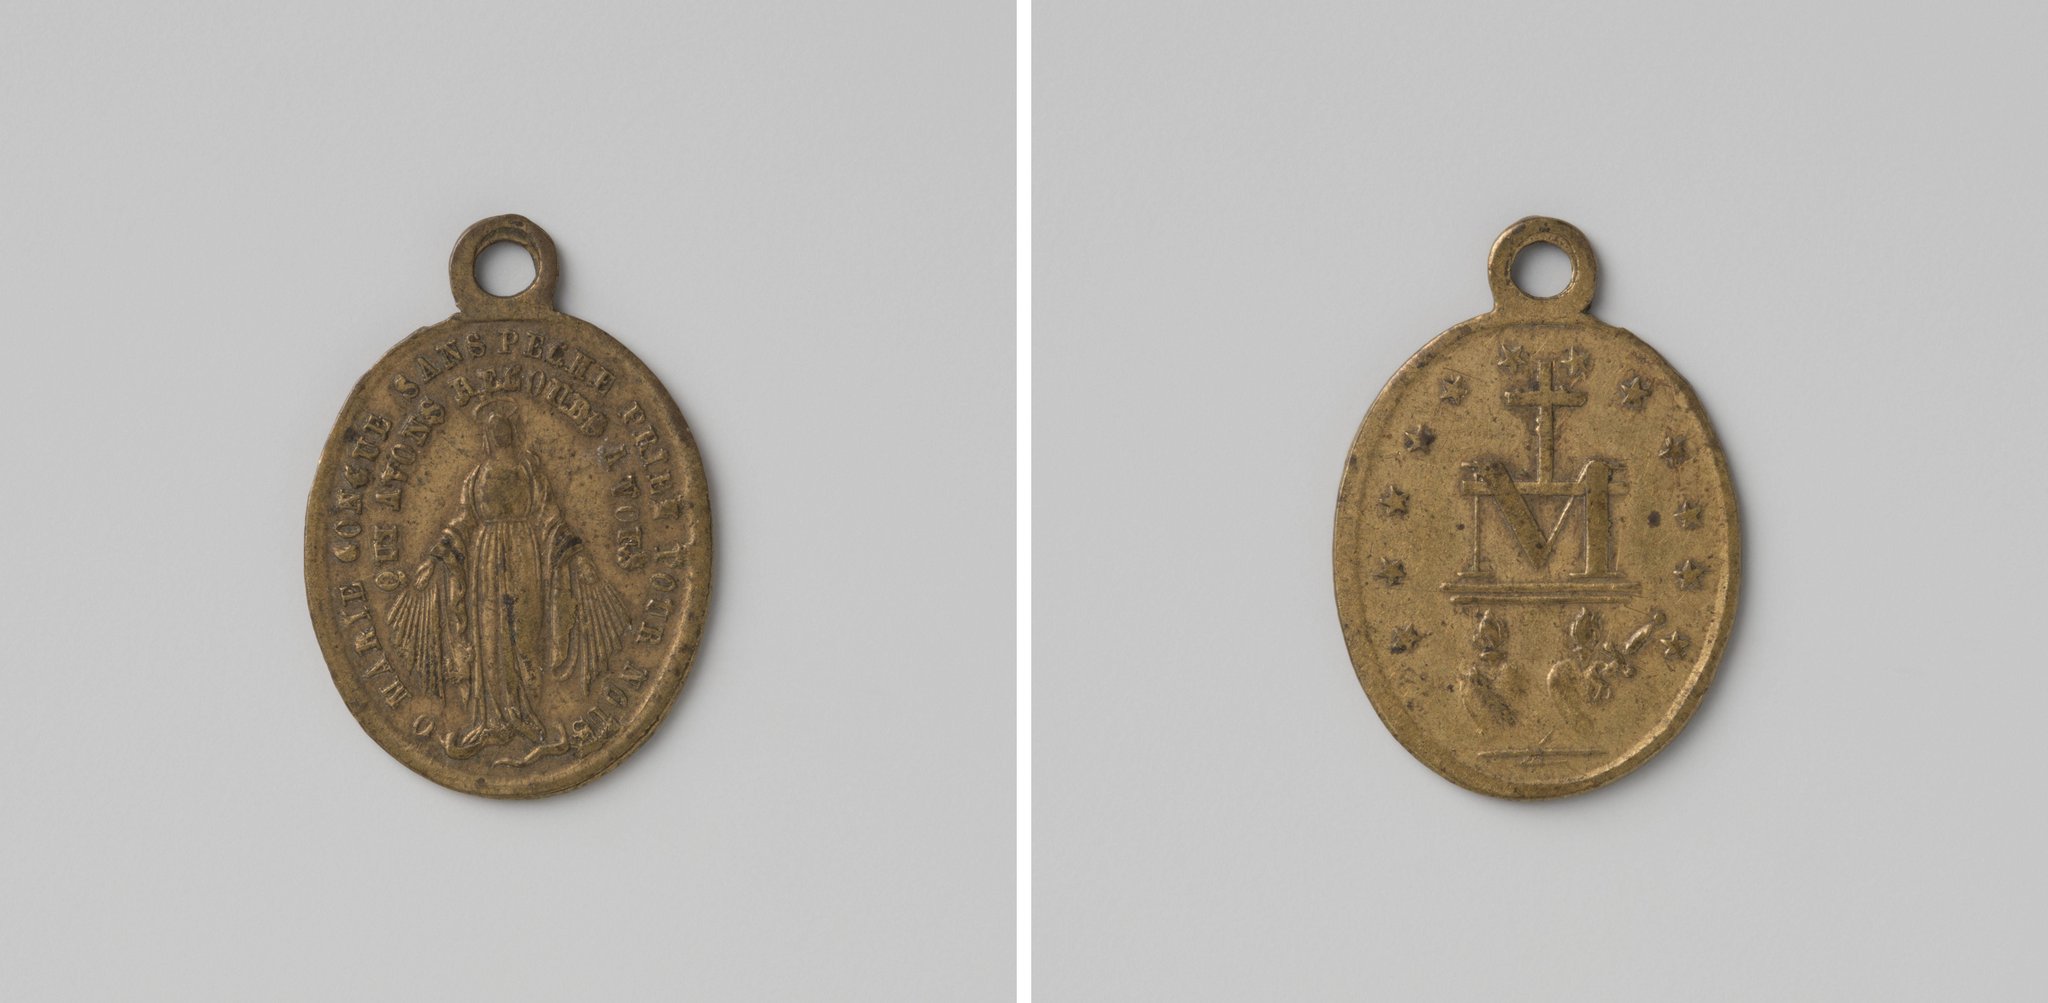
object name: devotional token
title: Mirakuleuze medaille, devotiepenning gewijd aan de Onbevlekte Ontvangenis van de Maagd Maria en de devotie tot de Heilige Harten van Christus en Maria, vervaardigd naar aanleiding van de verschijning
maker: Anonymous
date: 1830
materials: brass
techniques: striking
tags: paris